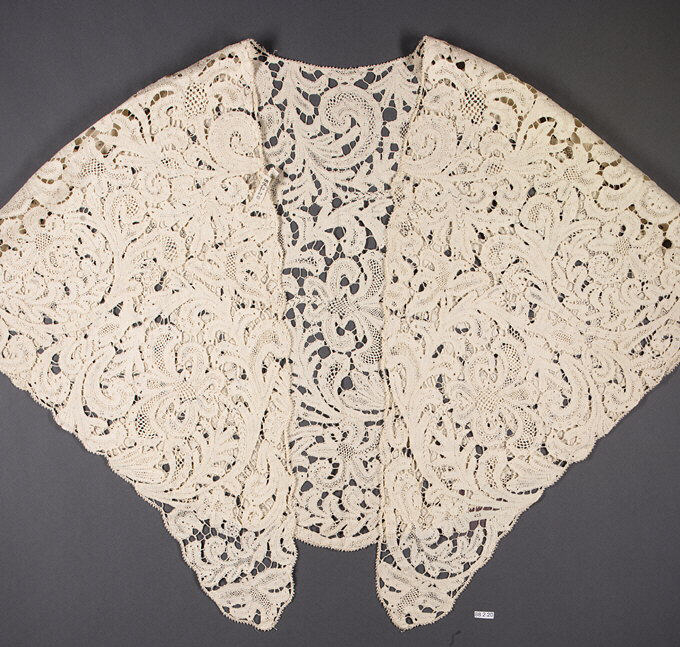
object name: cape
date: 1650-1700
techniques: lace